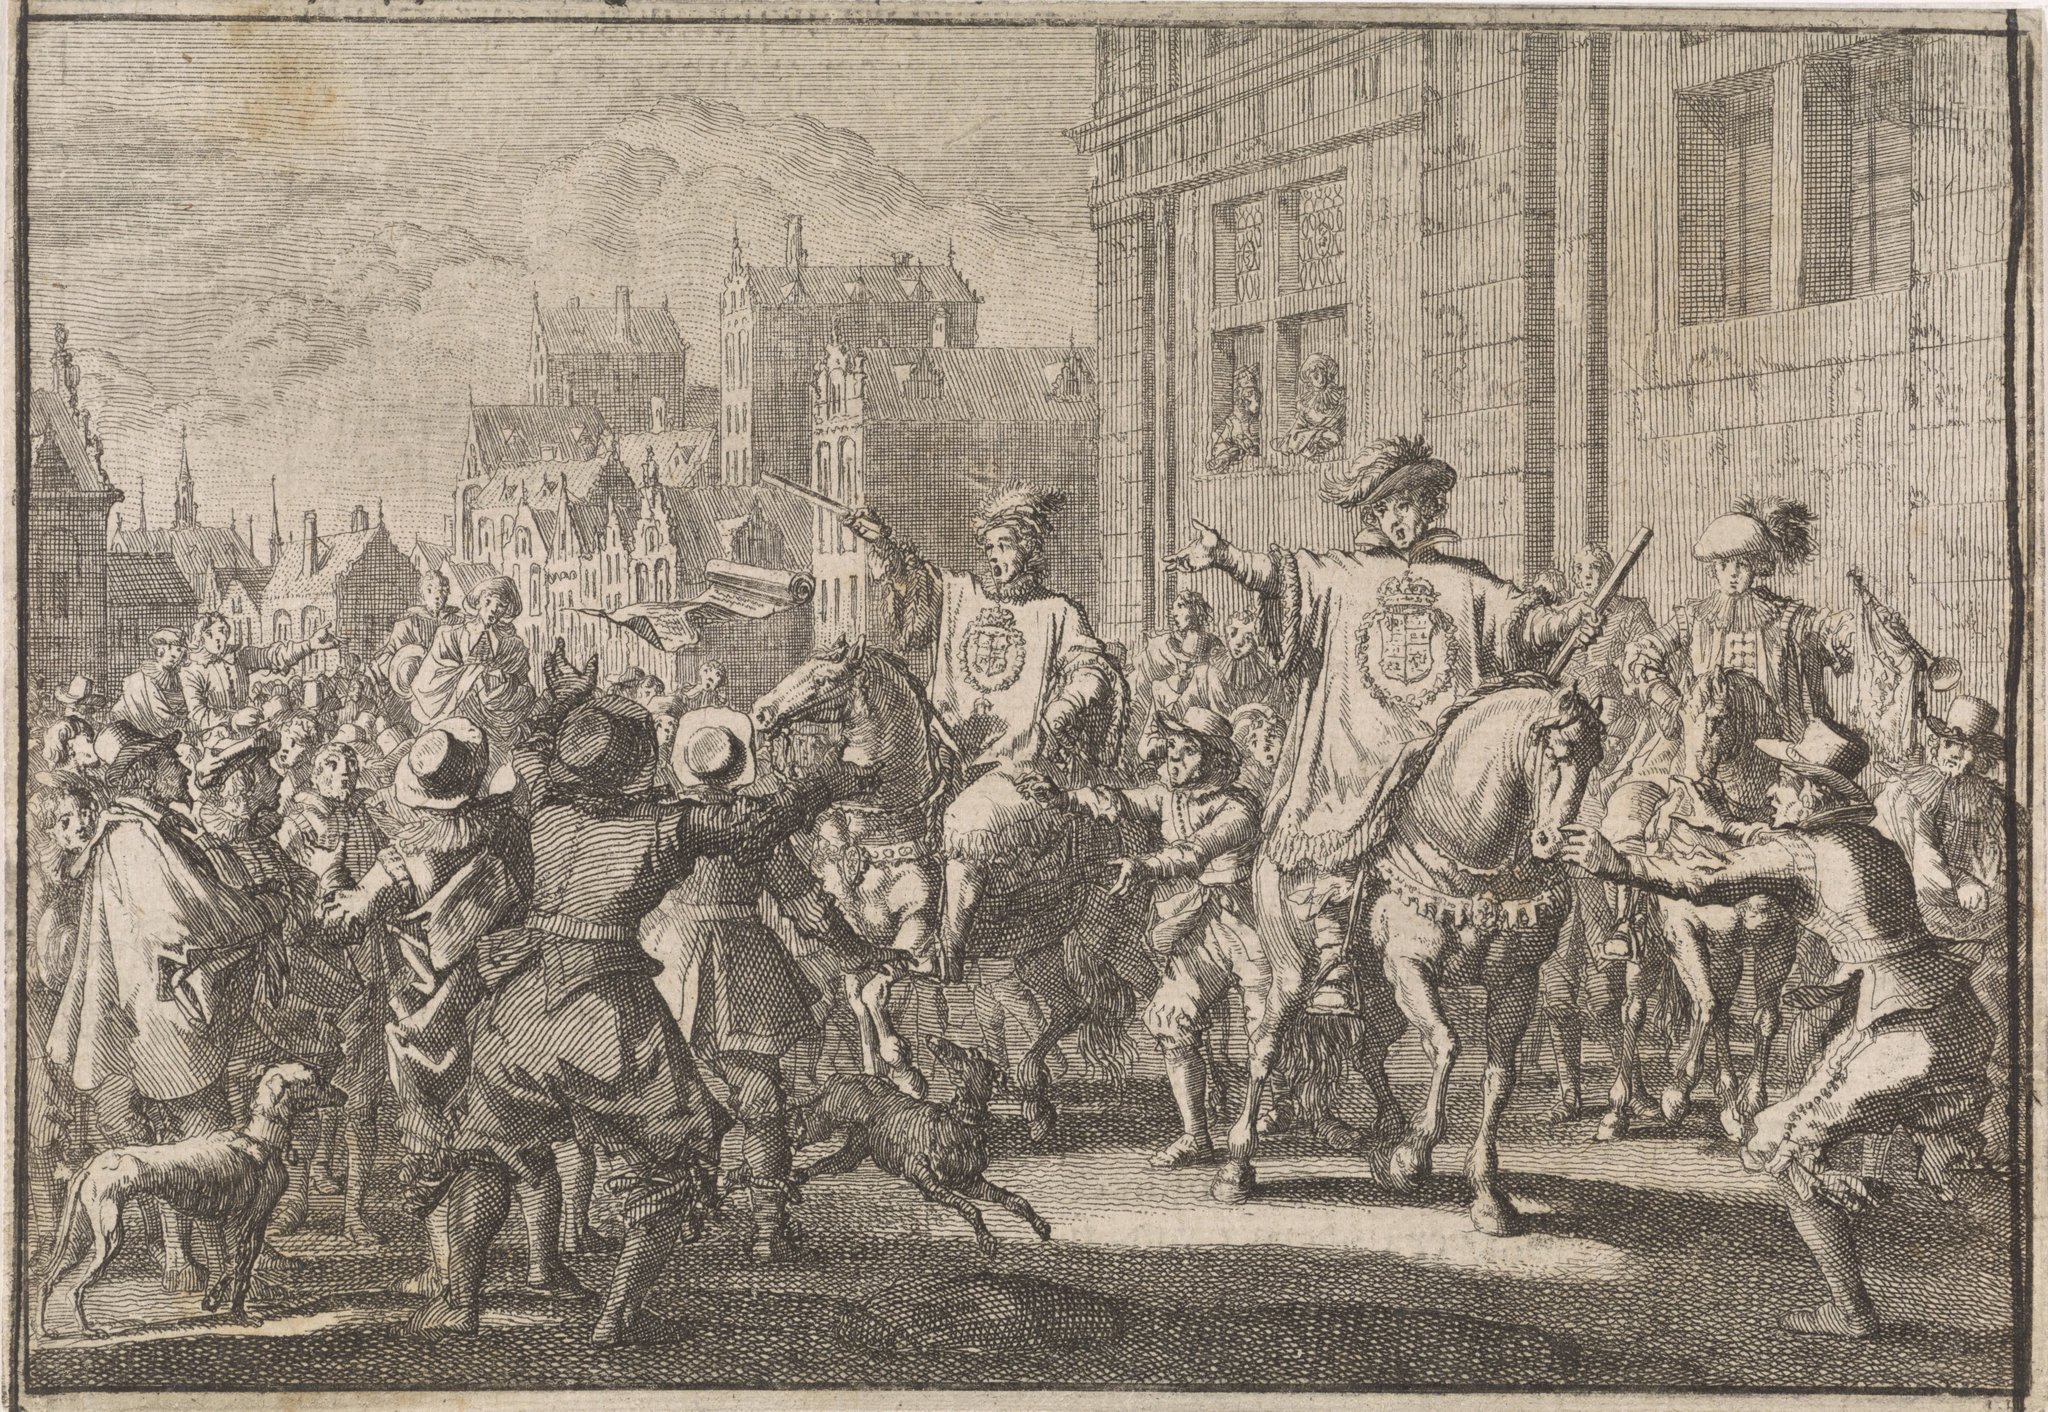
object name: book illustration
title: Heraut van koning Lodewijk XIII leest op straat de oorlogsverklaring aan Spanje voor, 1635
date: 1701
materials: paper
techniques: etching, letterpress printing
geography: amsterdam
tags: lodewijk xiii (koning van frankrijk), declaration of war, herald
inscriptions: collector's mark: Lugt 2228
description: Boekillustratie voor Hiob Ludolff. Allgemeine Schau-Bühne der Welt. Deel II. Frankfurt am Main: Johann David Zunnern, 1701, p. 436.